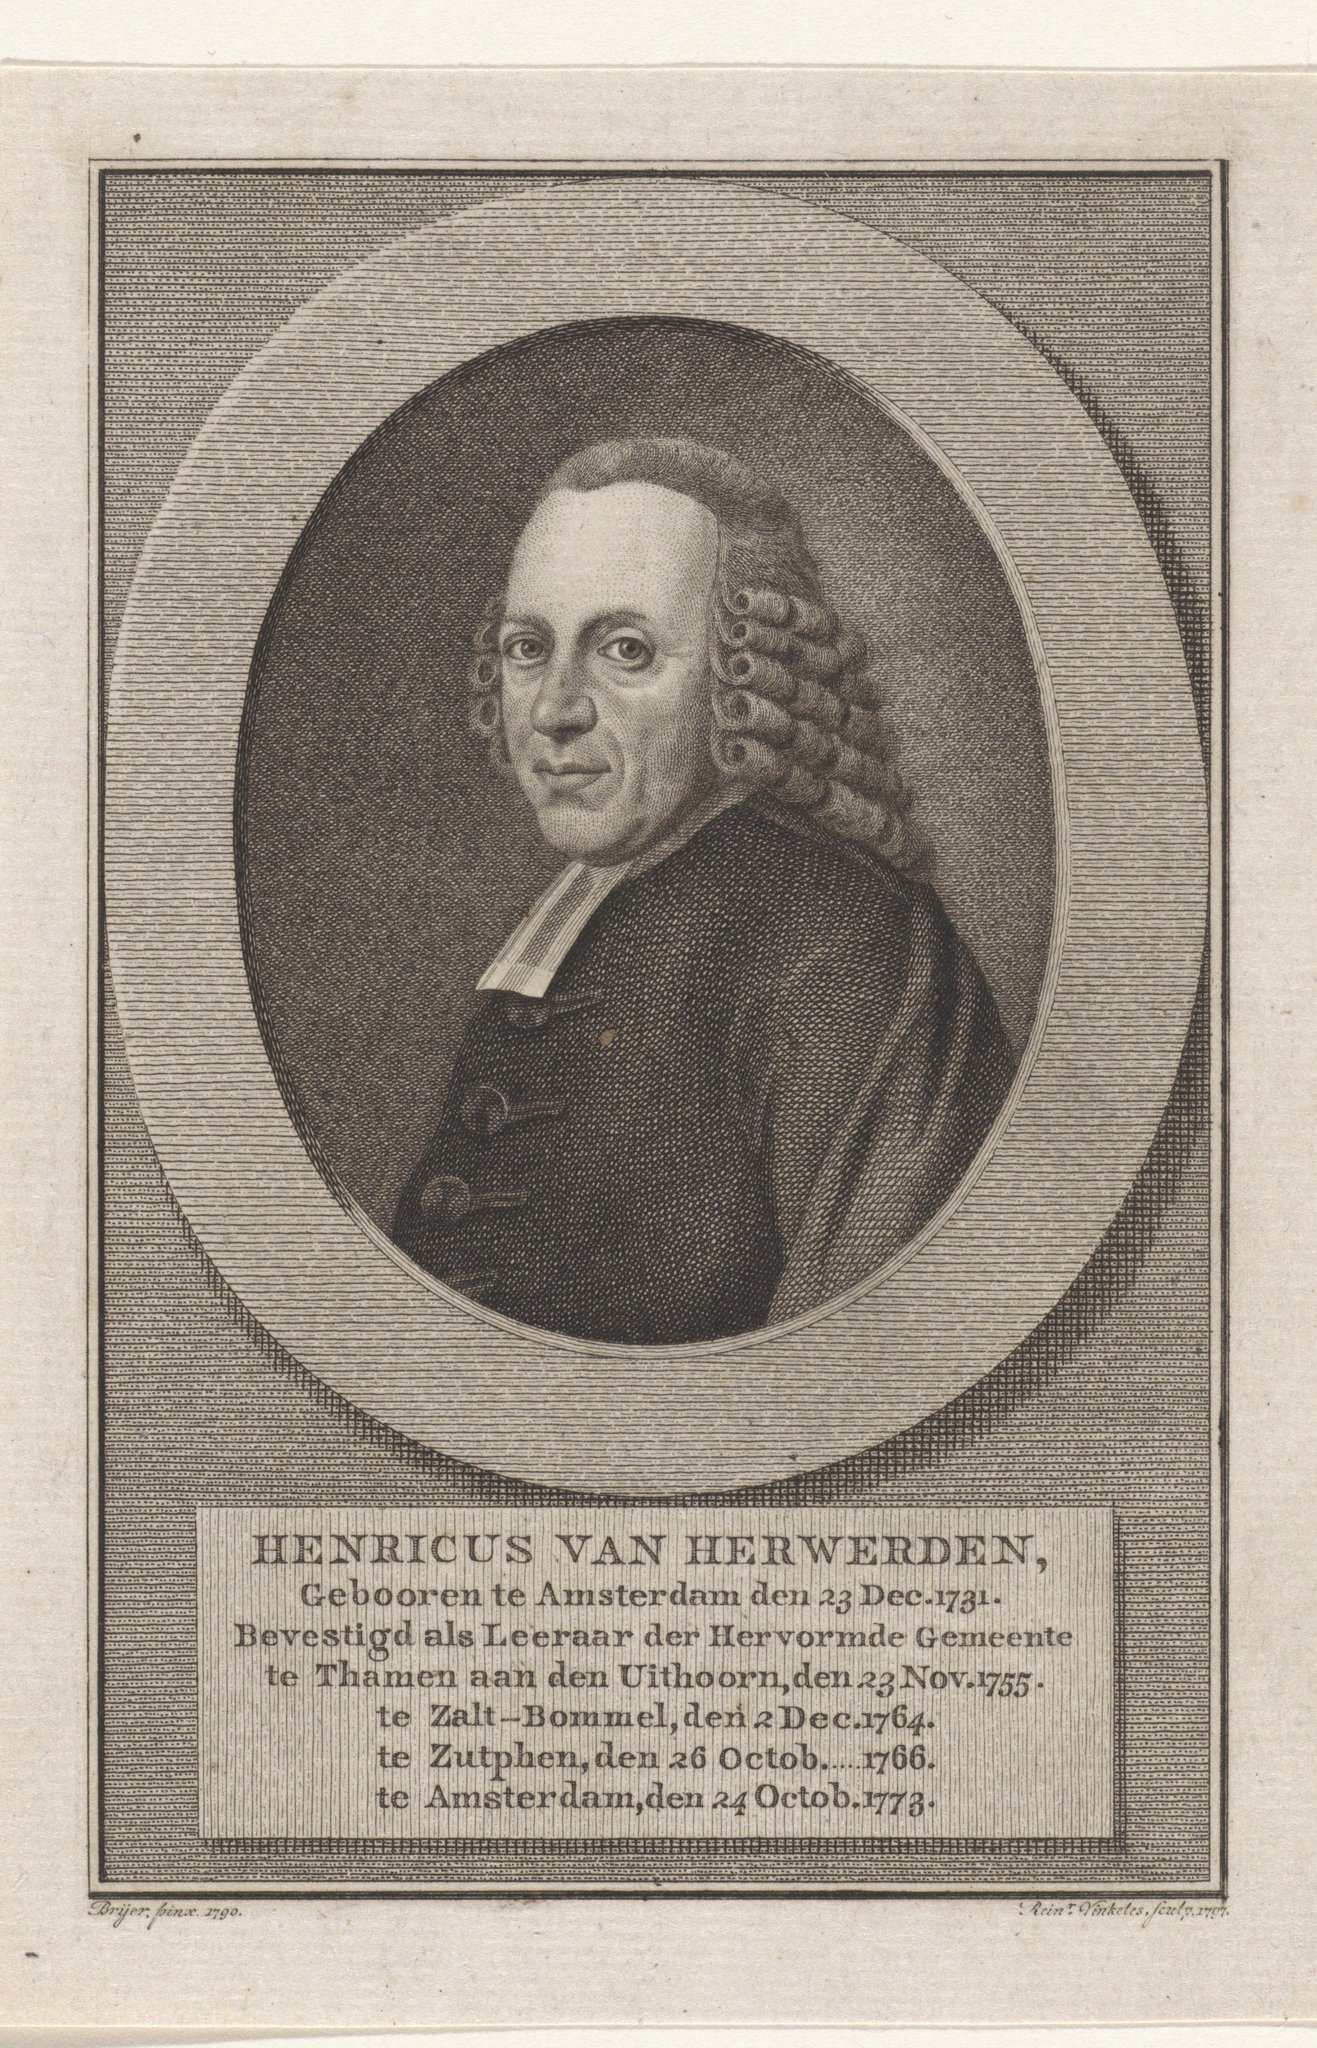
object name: print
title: Portret van Henricus van Herwerden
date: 1797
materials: paper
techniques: engraving, etching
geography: amsterdam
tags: predikant, henricus van herwerden (i)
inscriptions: collector's mark: Lugt 2228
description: Portret van de Amsterdamse predikant Henricus van Herwerden.